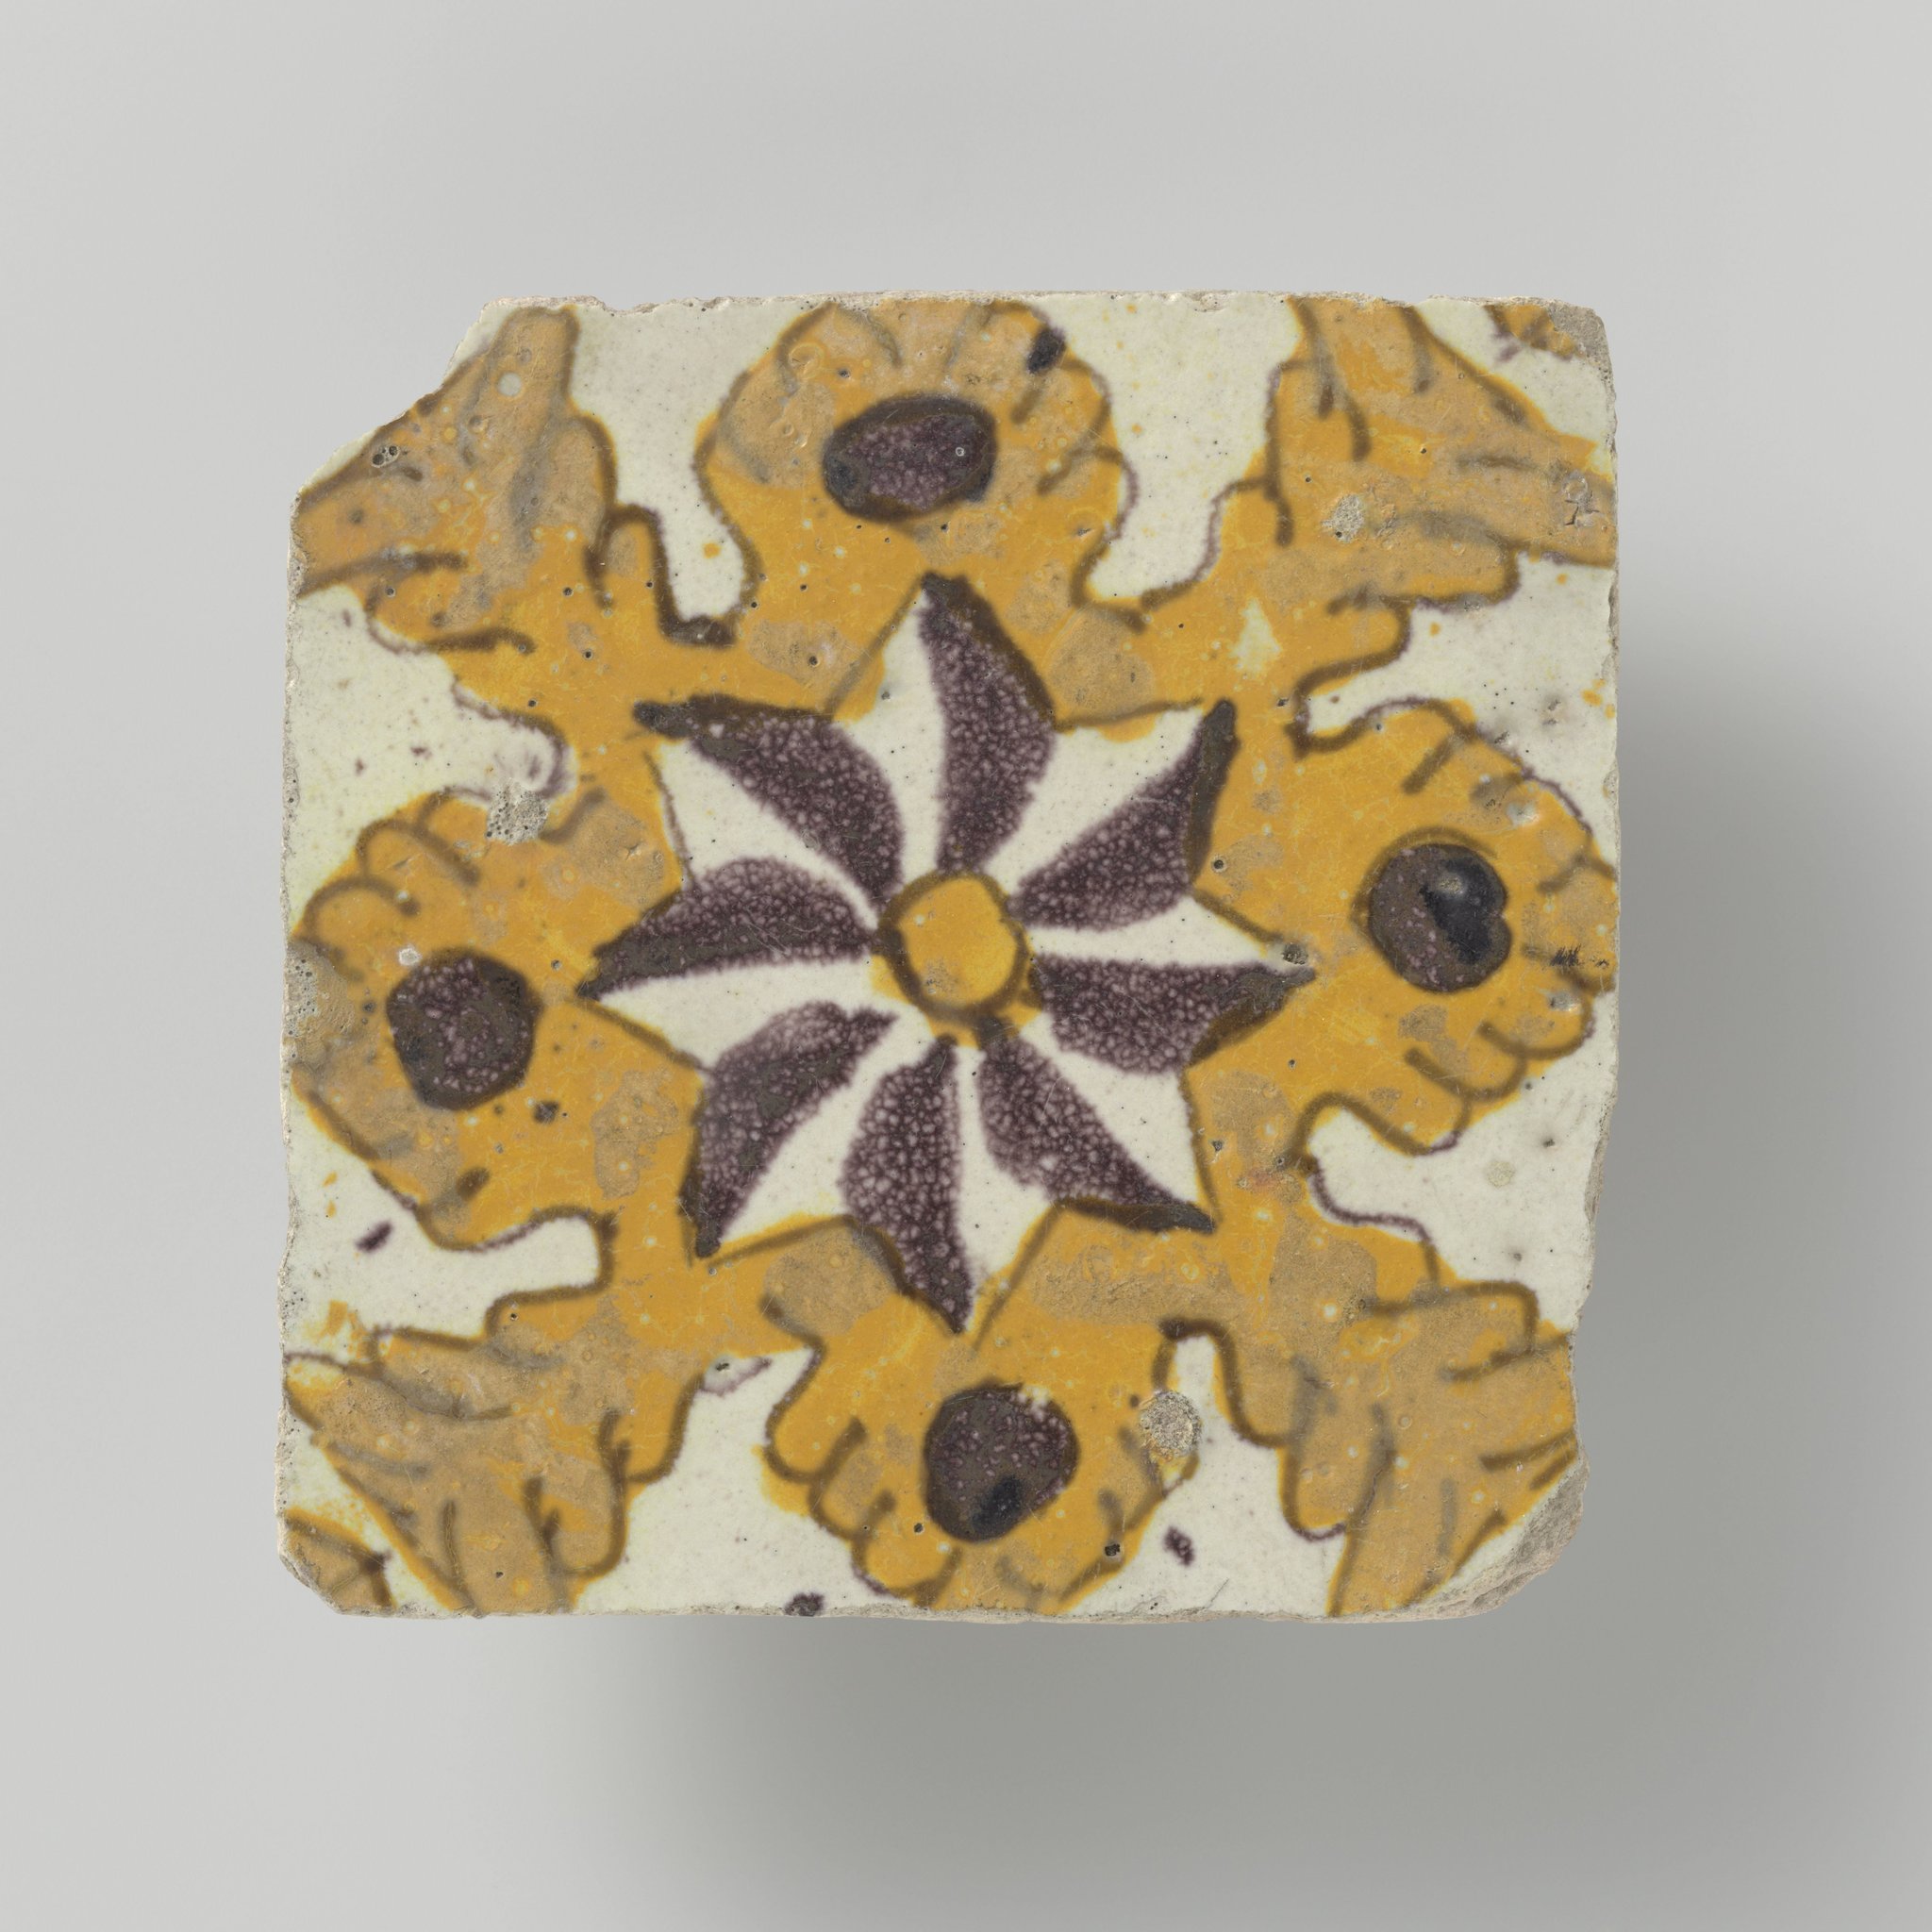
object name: tile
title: Tegel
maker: Anonymous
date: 1600-1800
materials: earthenware, glaze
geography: tunisia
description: Tegel, beschilderd in geel, mangaan. Gelobd rozet, waarin een achtpuntige ster. In de hoeken kwart achthoeken, met een dunne lijn met het rozet verbonden.